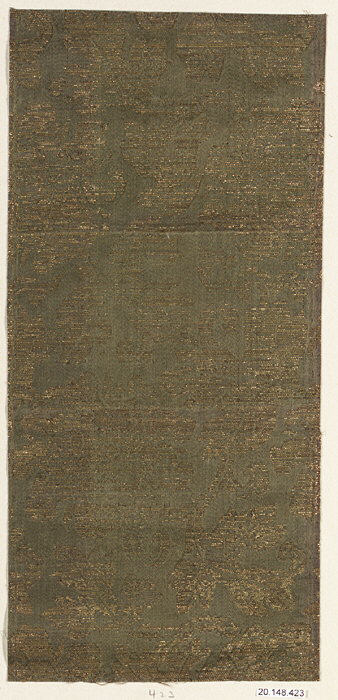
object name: piece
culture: japanese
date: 1701-1800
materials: silk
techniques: compound weave